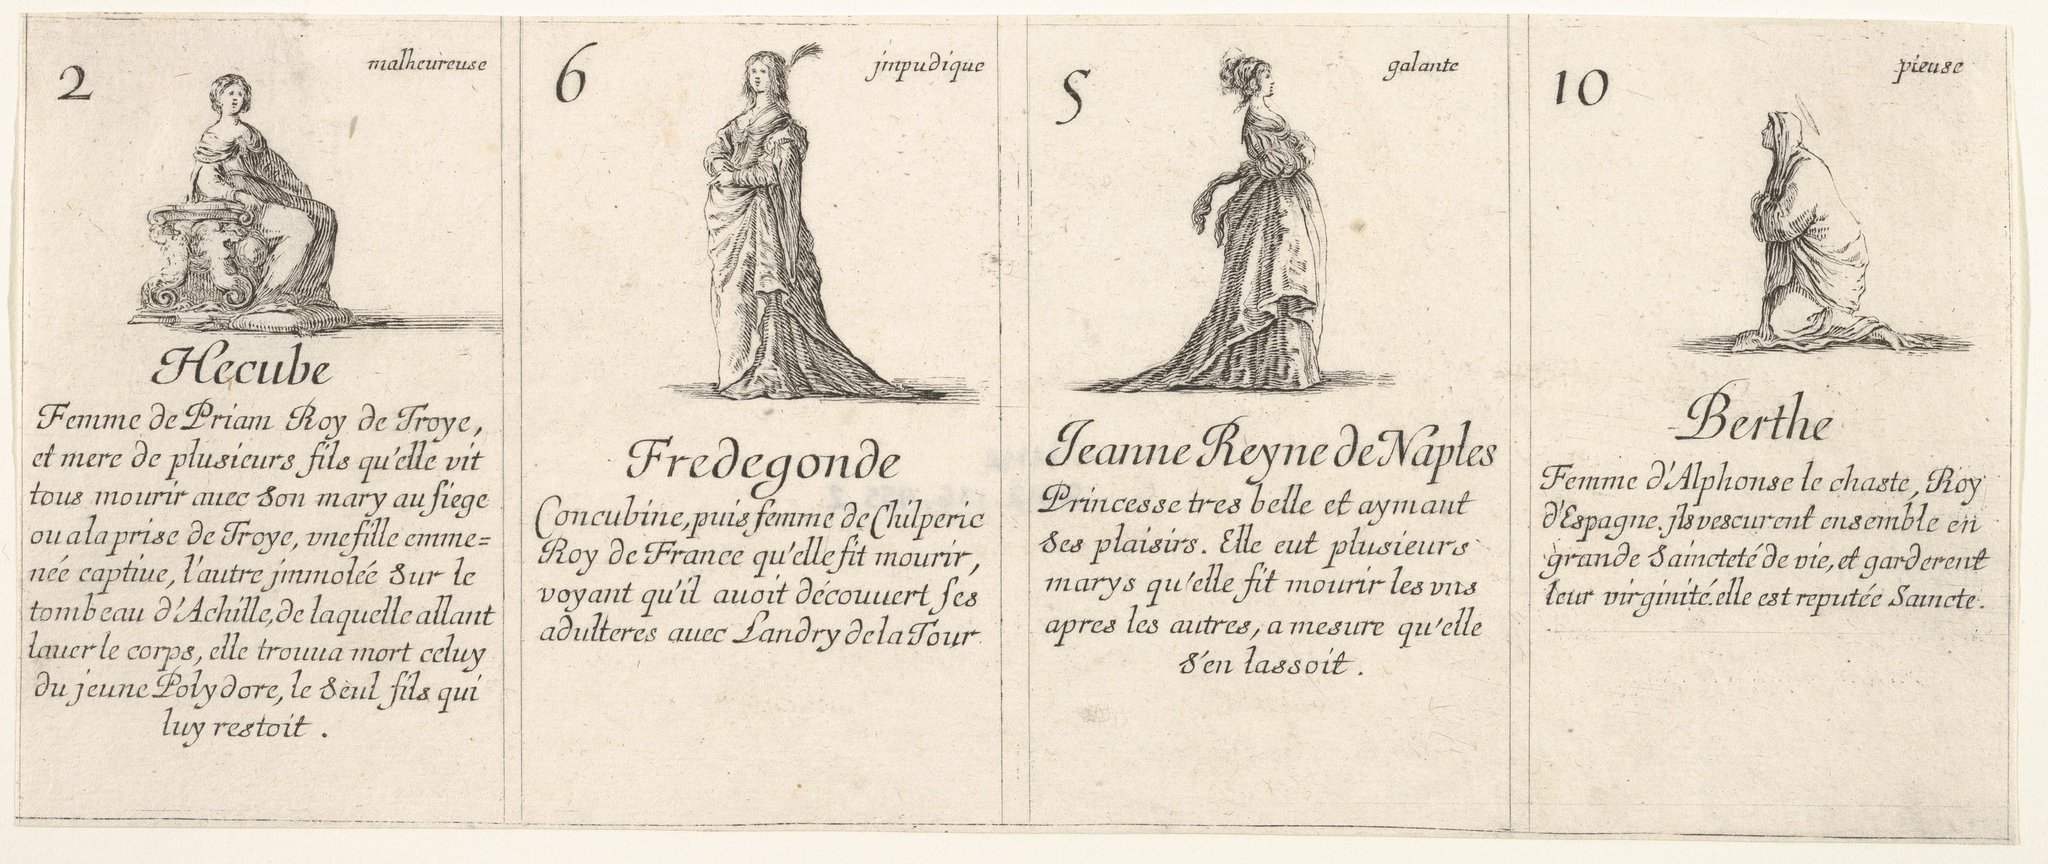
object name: print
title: Hecube, Fredegonde, Ieanne Reyne de Naples, and Berthe, from "The Game of Queens" (Le Jeu des Reines Renommées)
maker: stefano della bella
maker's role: artist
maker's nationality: italian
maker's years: 1610-1664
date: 1644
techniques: etching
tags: queens